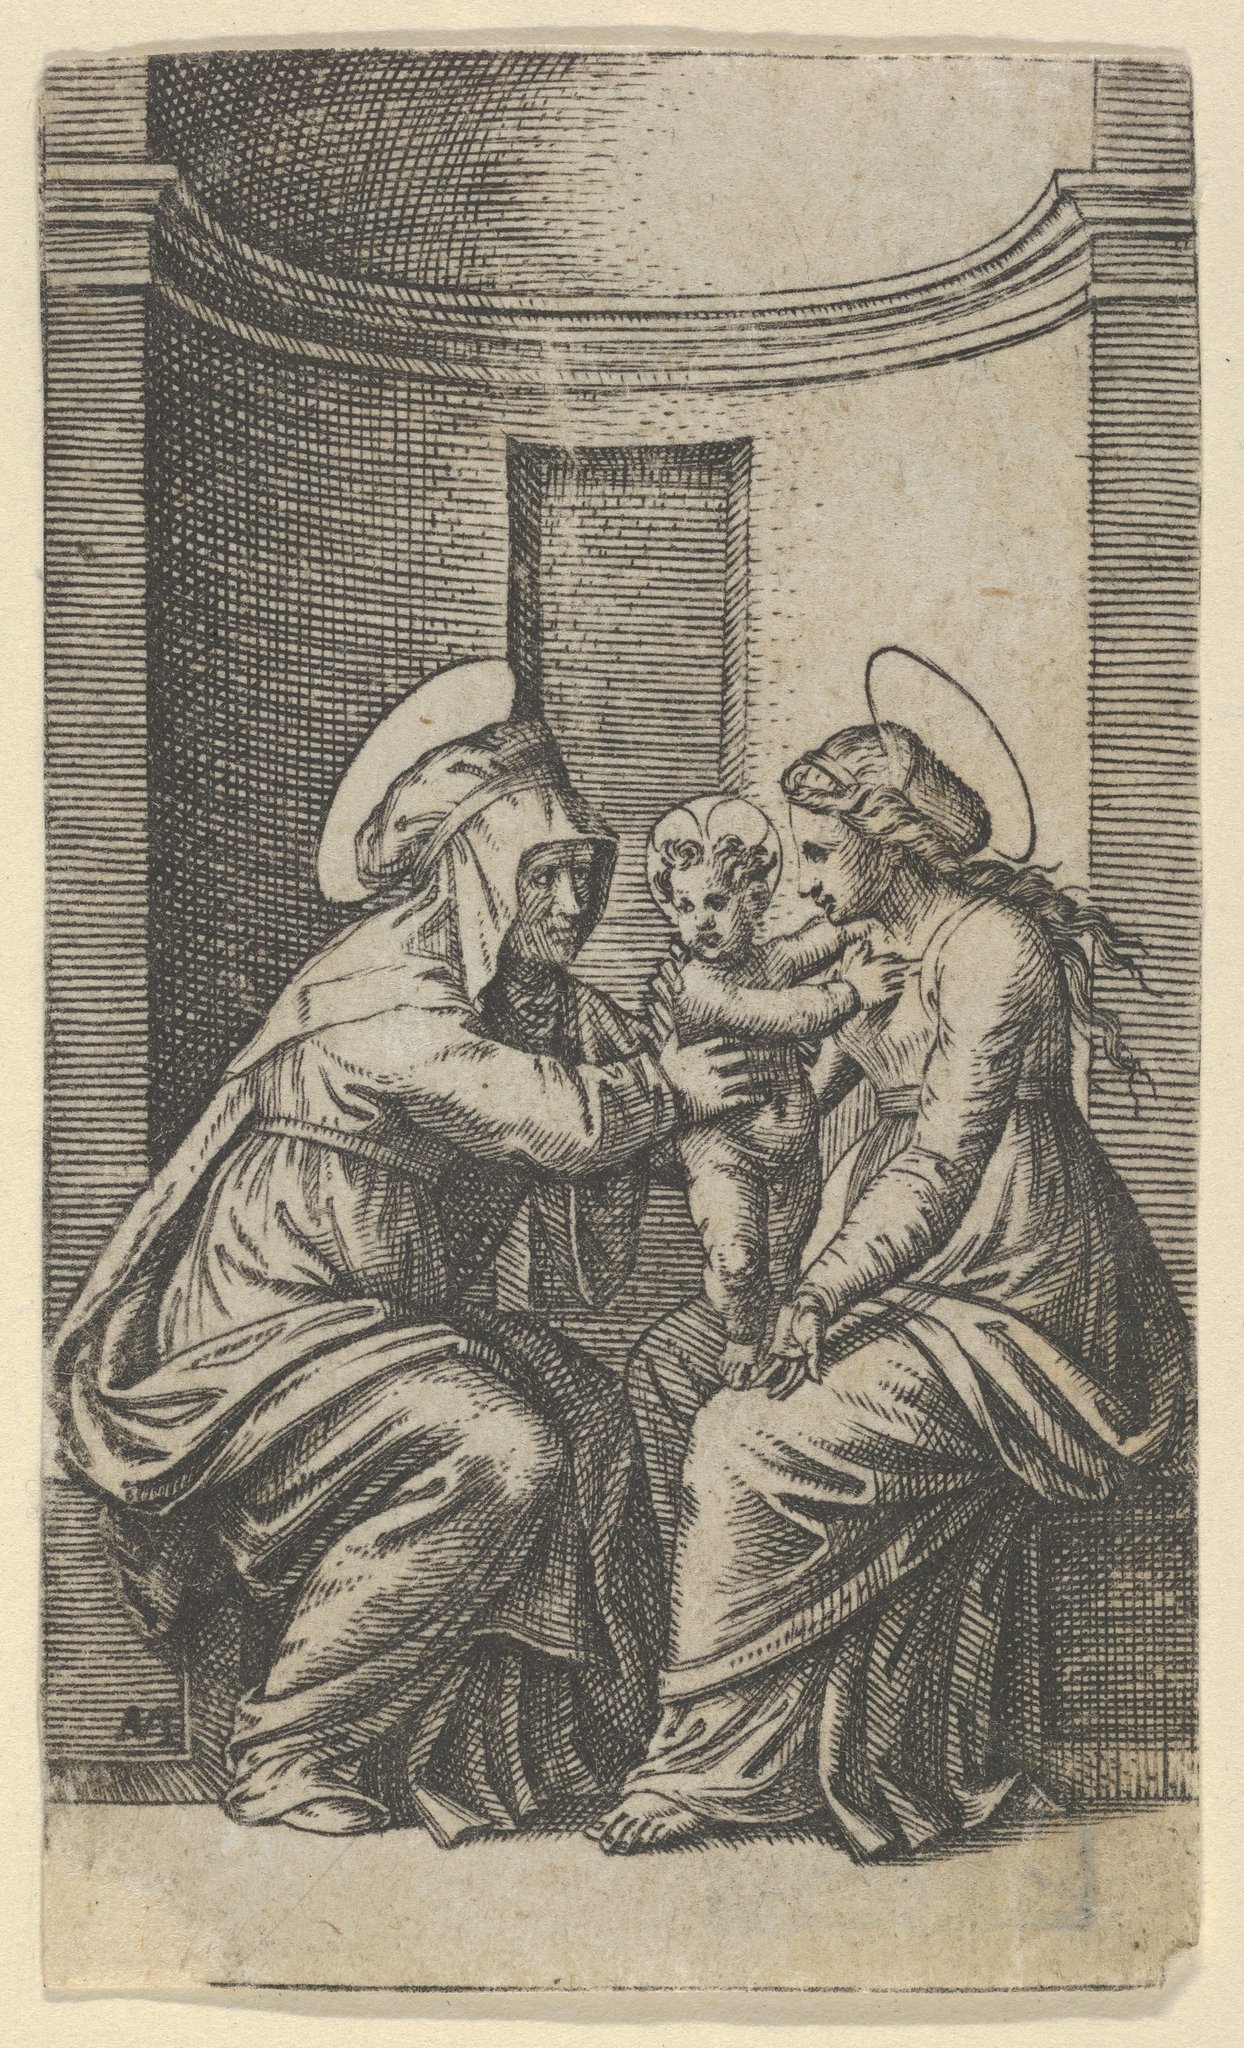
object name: print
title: Saint Anne and the Virgin with the Infant Christ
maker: marcantonio raimondi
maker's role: artist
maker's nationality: italian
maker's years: 1475-1534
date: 1500-1527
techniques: engraving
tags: infants,saint anne,virgin mary